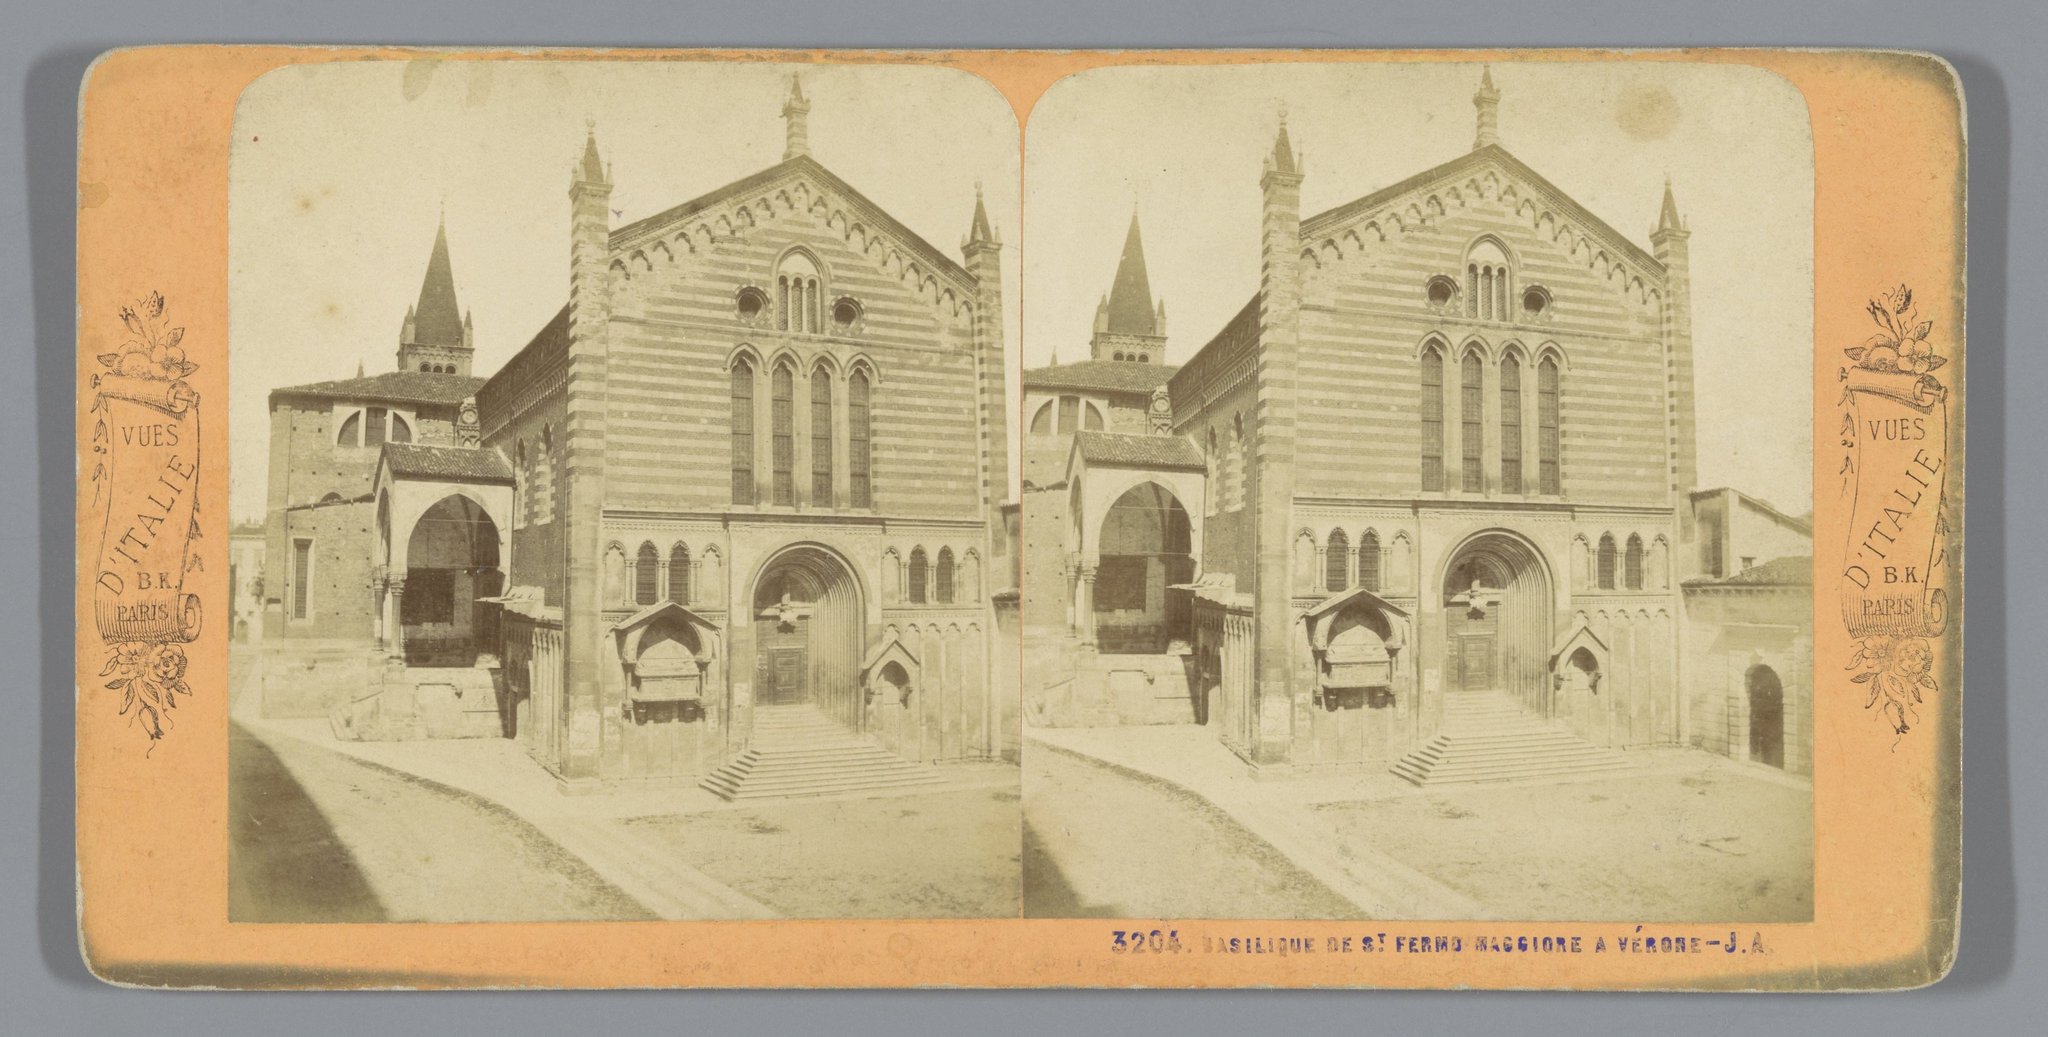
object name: stereograph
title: Basilique de St Fermo Maggiore a Vérone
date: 1872-1876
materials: cardboard, paper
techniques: albumen print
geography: paris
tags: abbey, monastery, convent ~ roman catholic church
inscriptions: number: ‘3204’